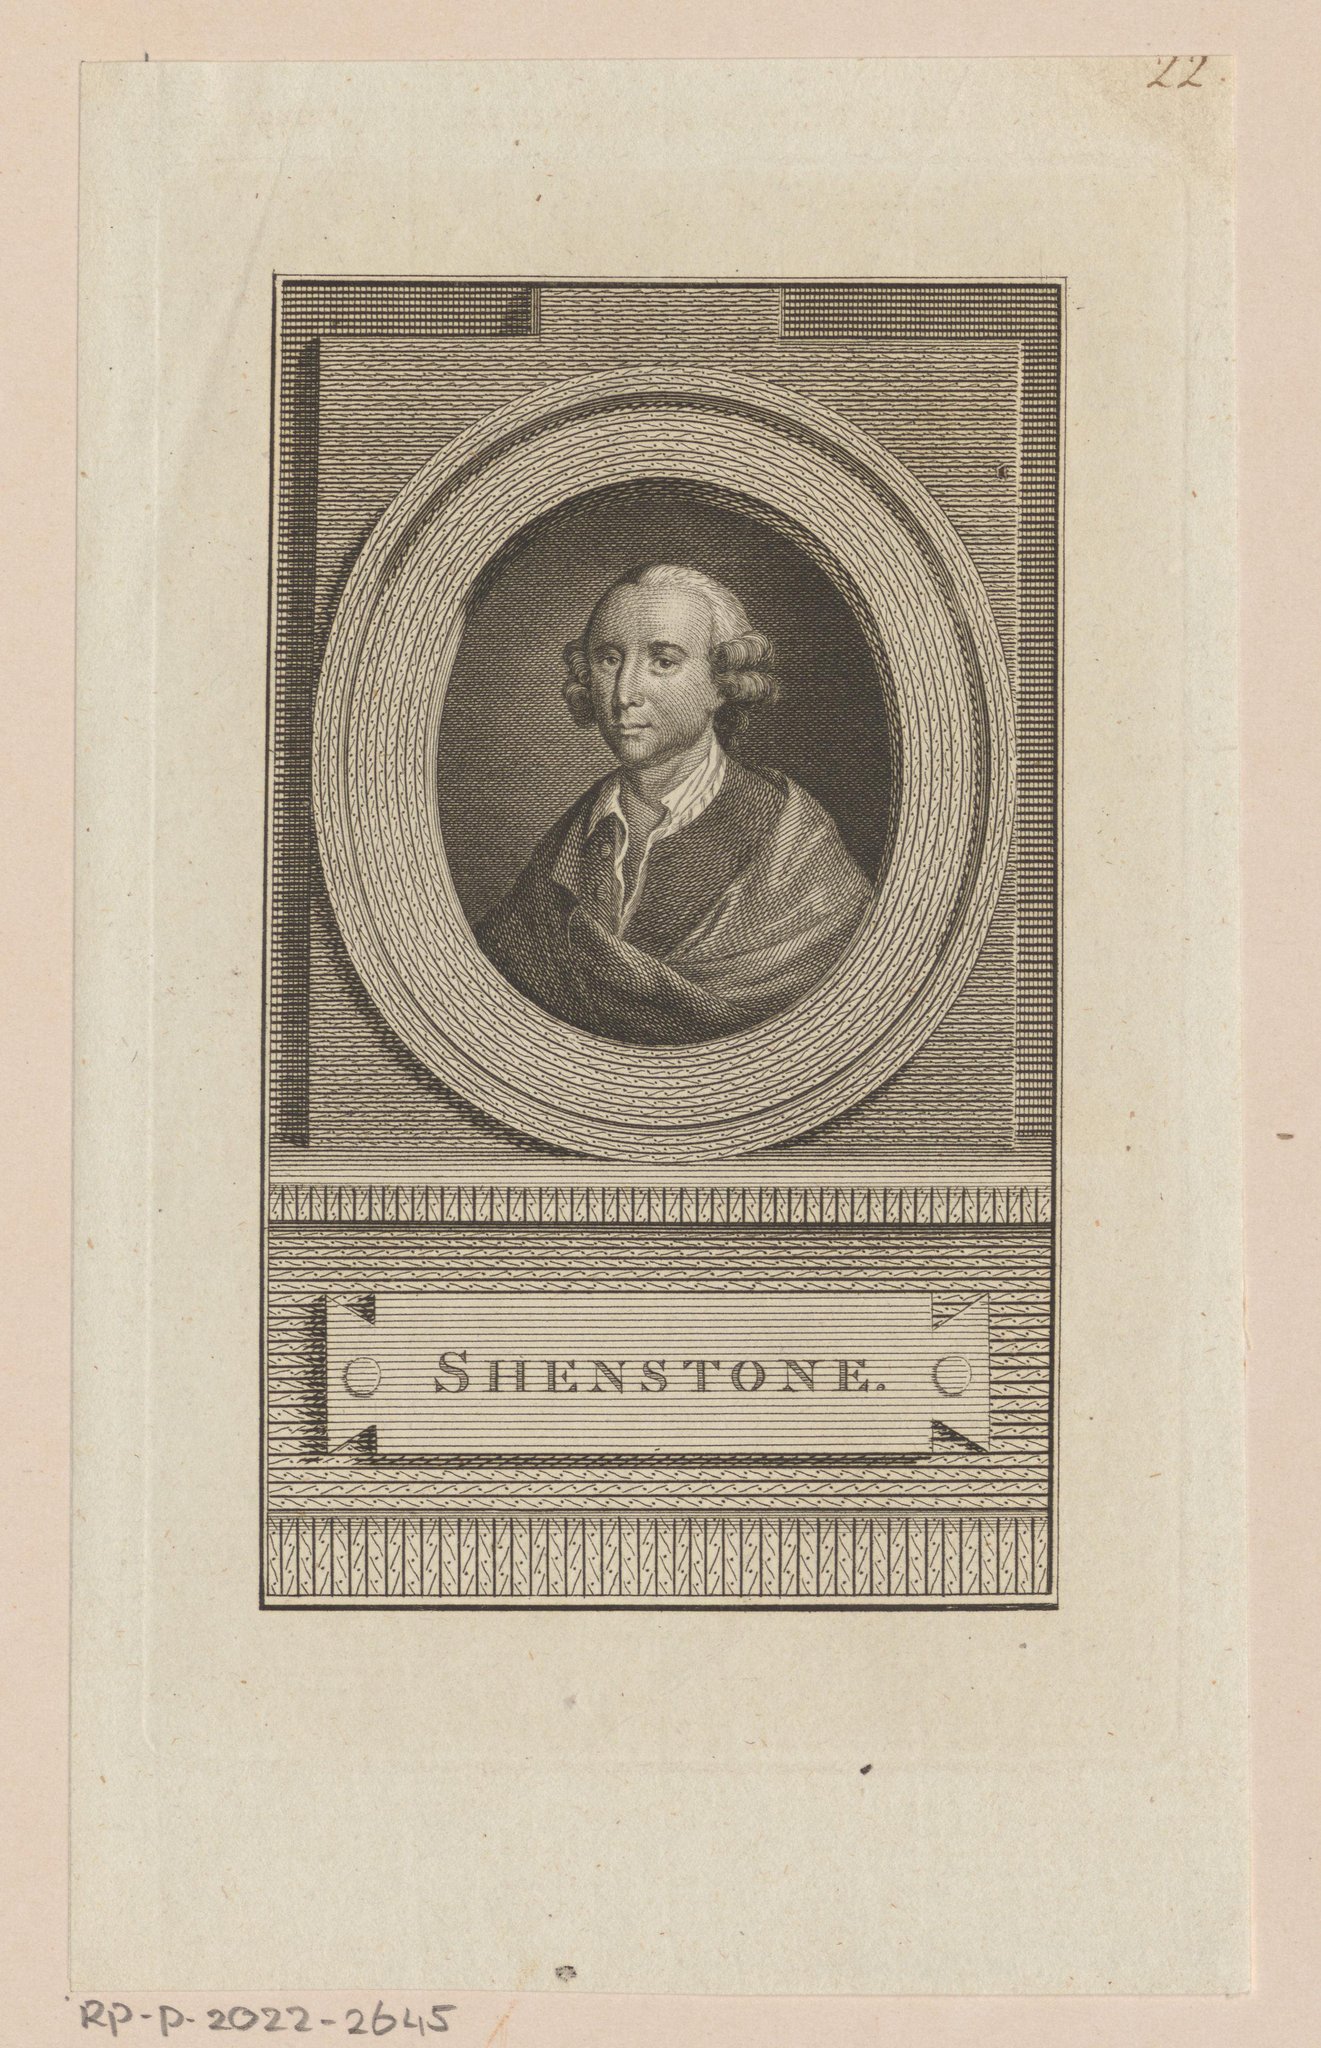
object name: print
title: Portret van William Shenstone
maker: Anonymous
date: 1744-1850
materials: paper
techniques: etching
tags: william shenstone, historical persons, portrait of a writer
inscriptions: number: ‘22’